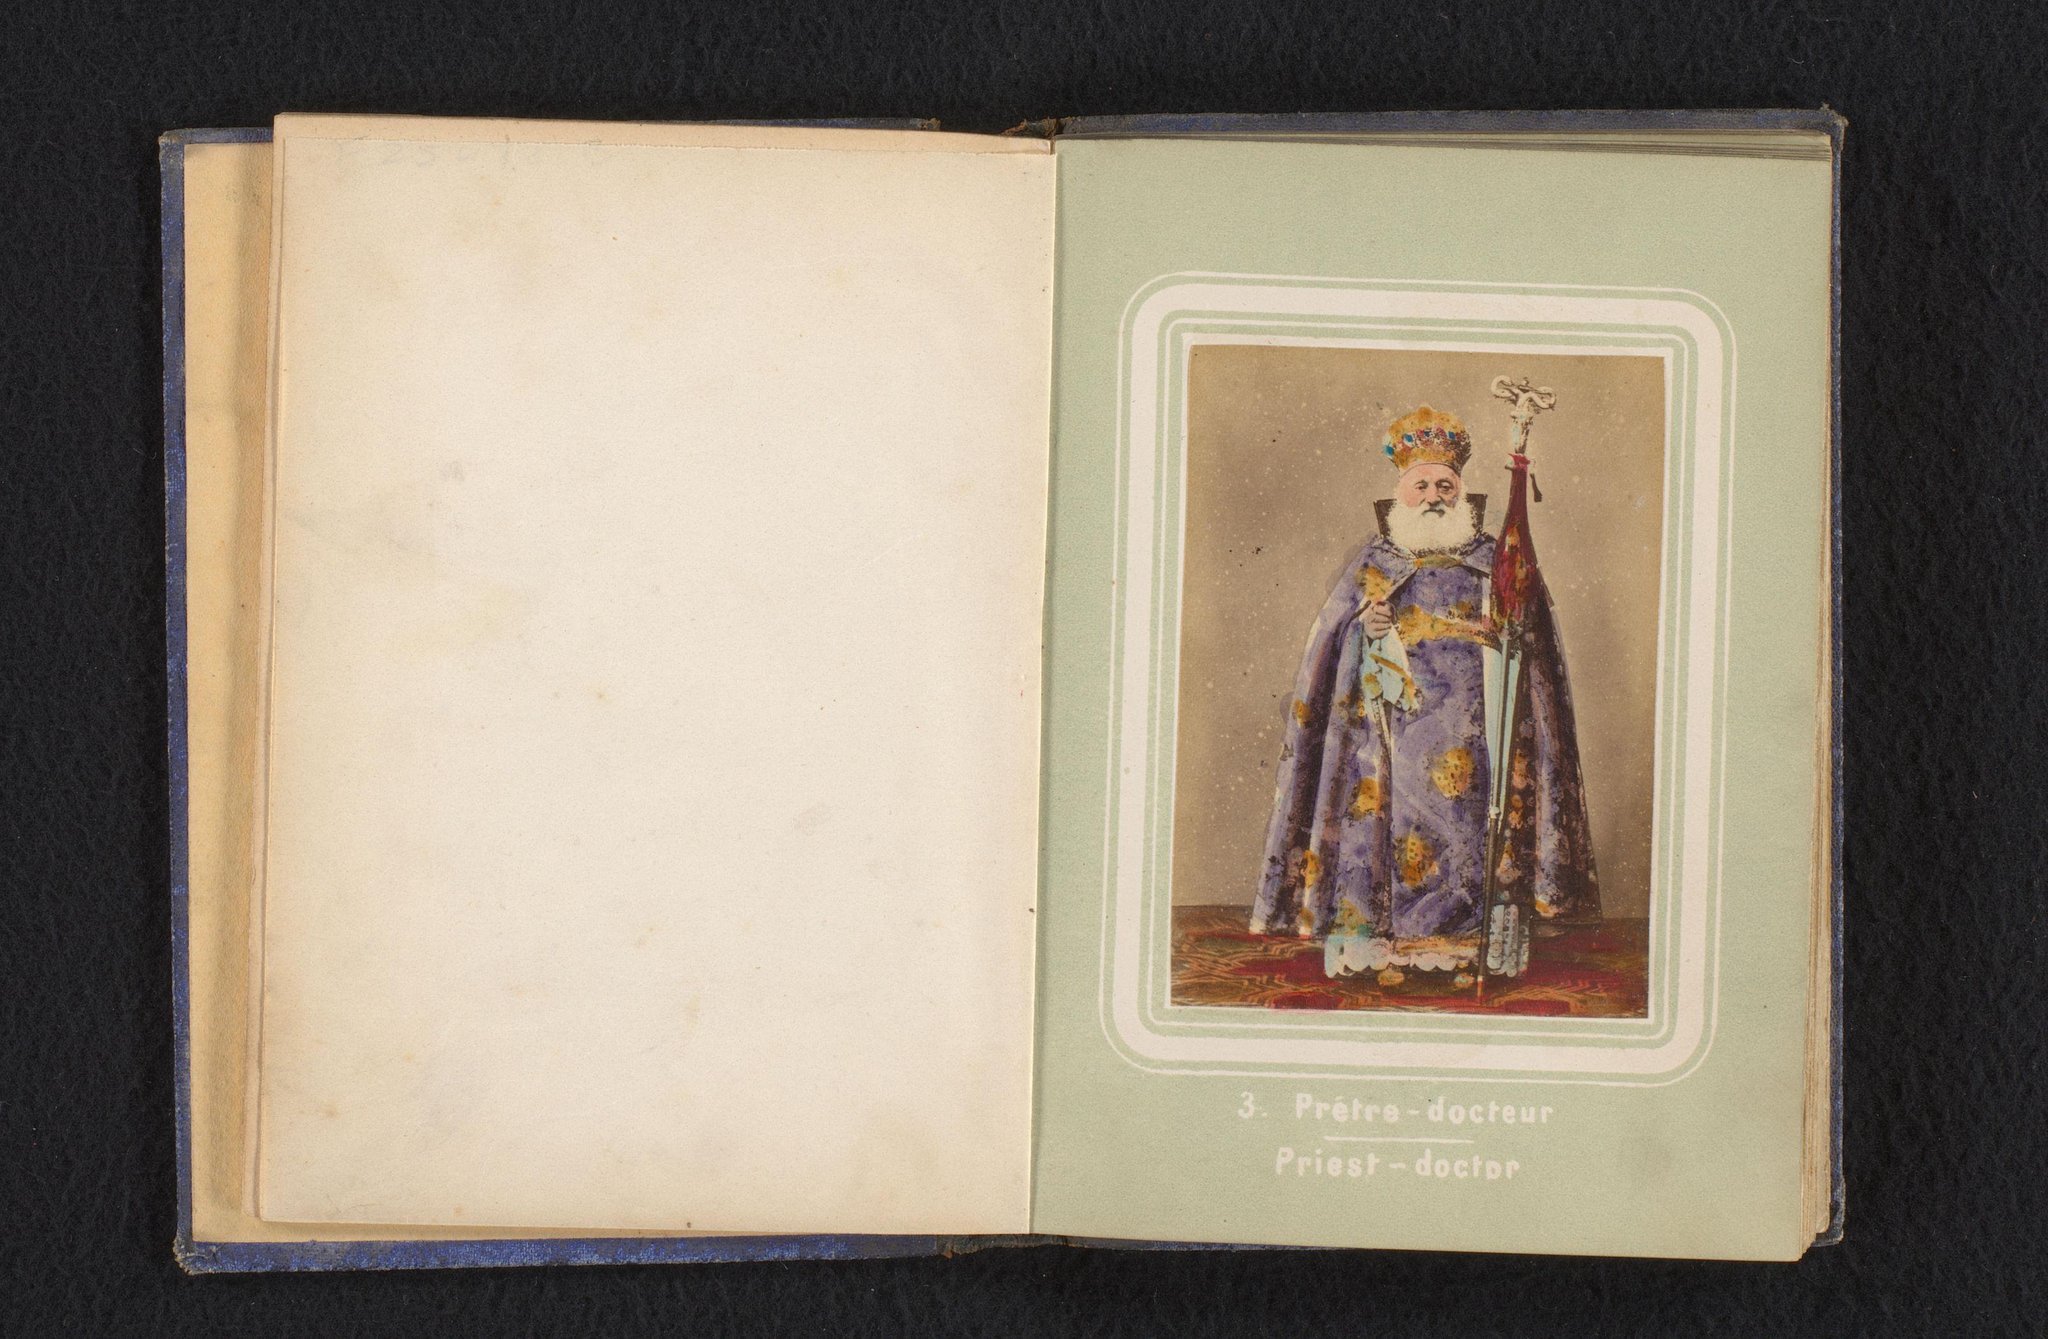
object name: page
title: Prêtre-docteur / Priest-doctor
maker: Anonymous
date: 1870-1890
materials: paper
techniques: albumen print, hand coloring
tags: physician, doctor, anonymous historical person portrayed, priests ~ hierarchy of priests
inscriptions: number: ‘3.’